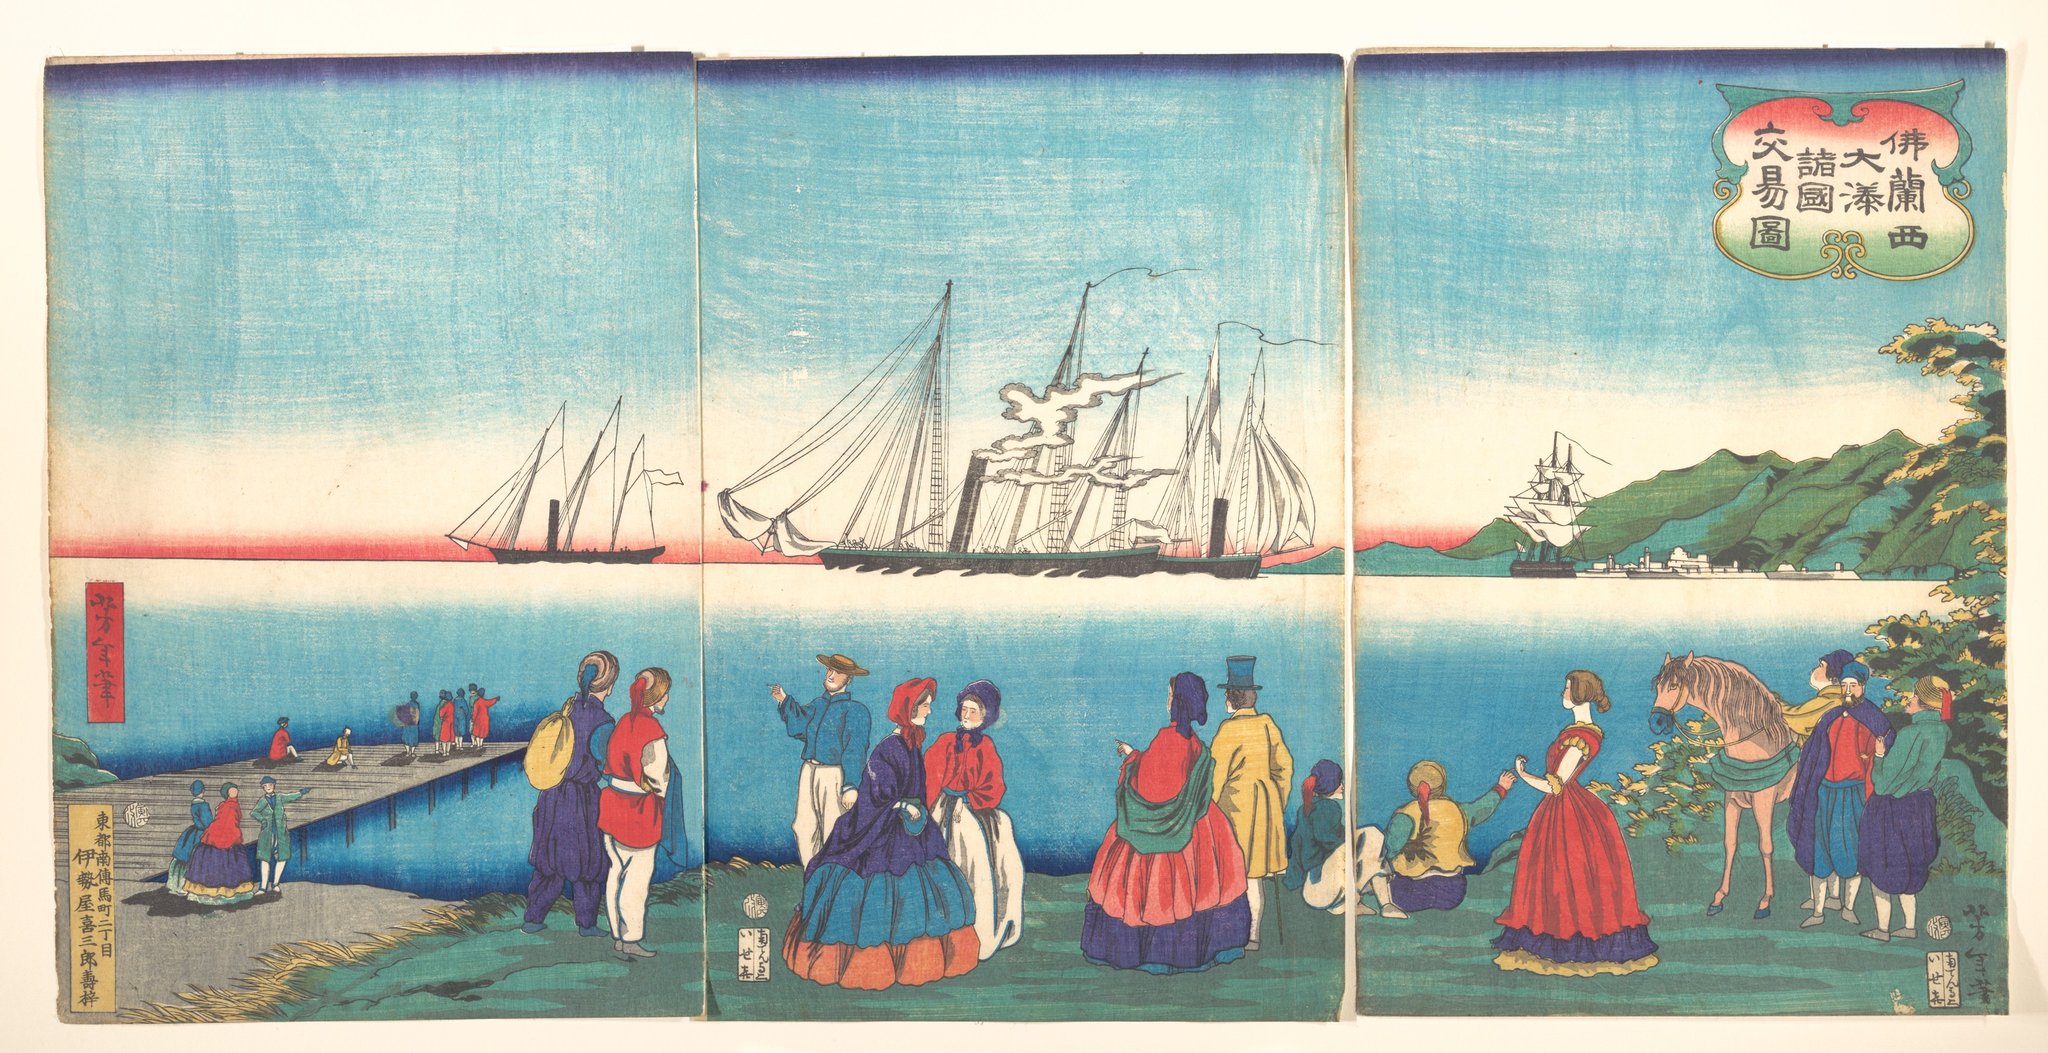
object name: print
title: Illustration of a Large French Port Trading with Many Nations (Furansukoku oominato shokoku kōeki zu)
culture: japanese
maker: tsukioka yoshitoshi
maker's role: artist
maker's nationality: japanese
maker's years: 1839-1892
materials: ink, paper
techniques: woodblock print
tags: men,women,horses,ships